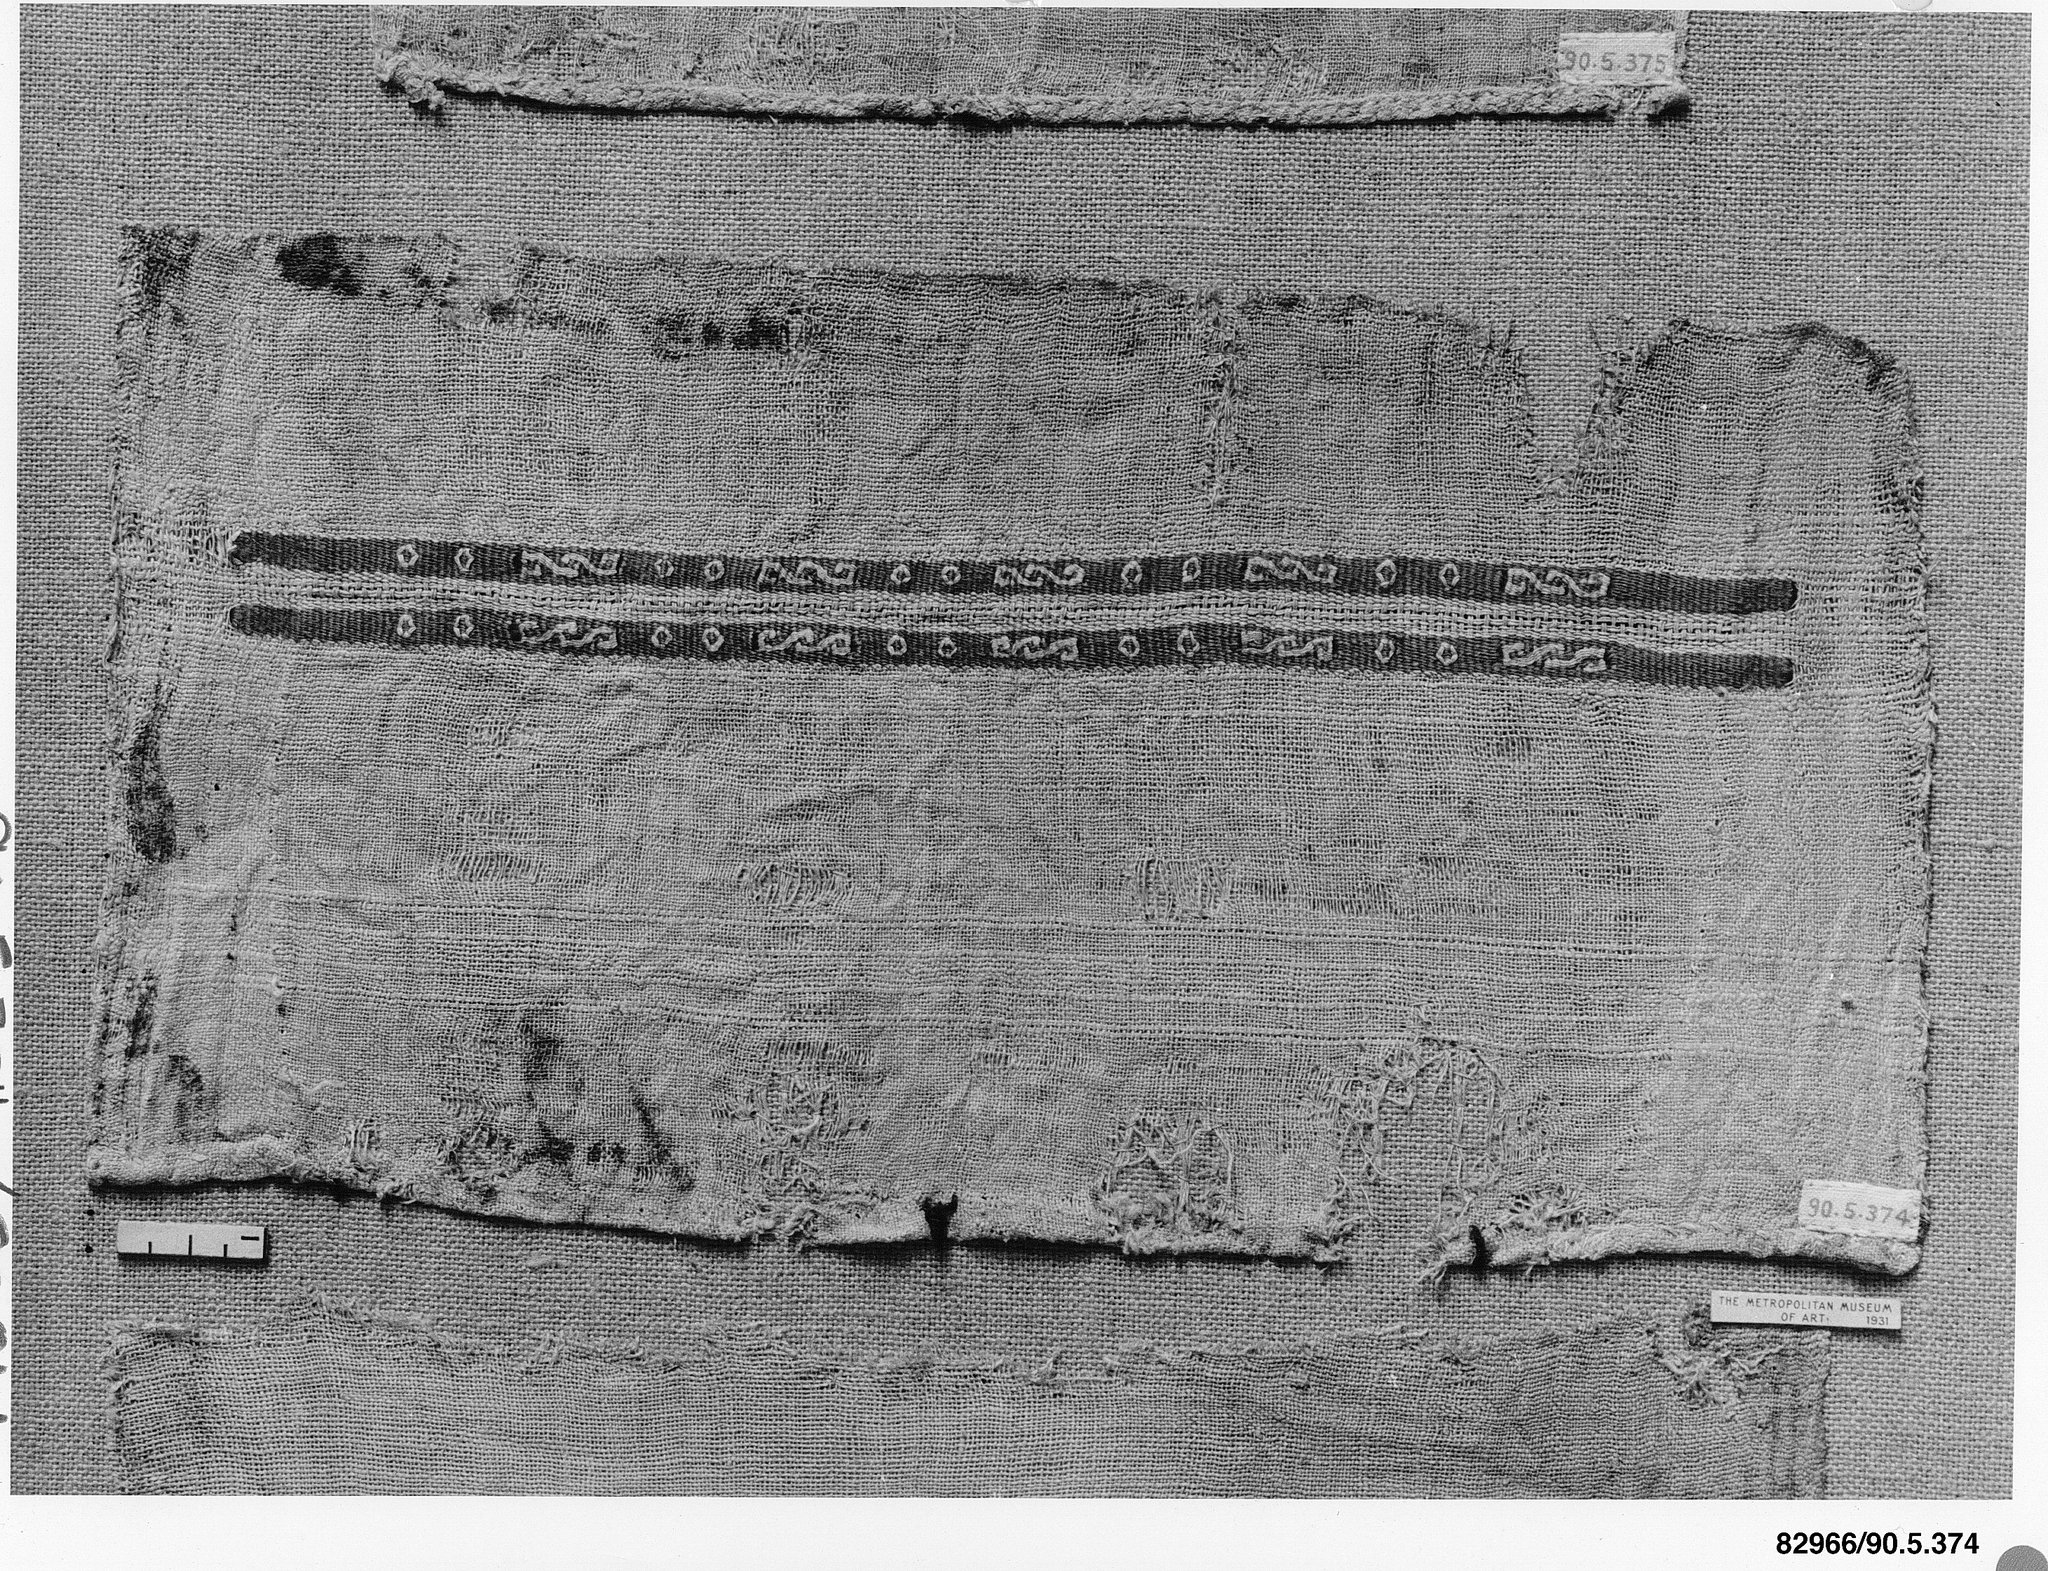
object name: textile fragment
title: Fragment of a Sleeve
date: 401-500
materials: linen, wool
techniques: weave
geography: egypt